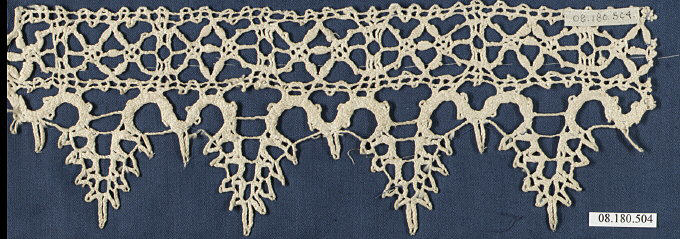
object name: fragment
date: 1501-1600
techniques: lace